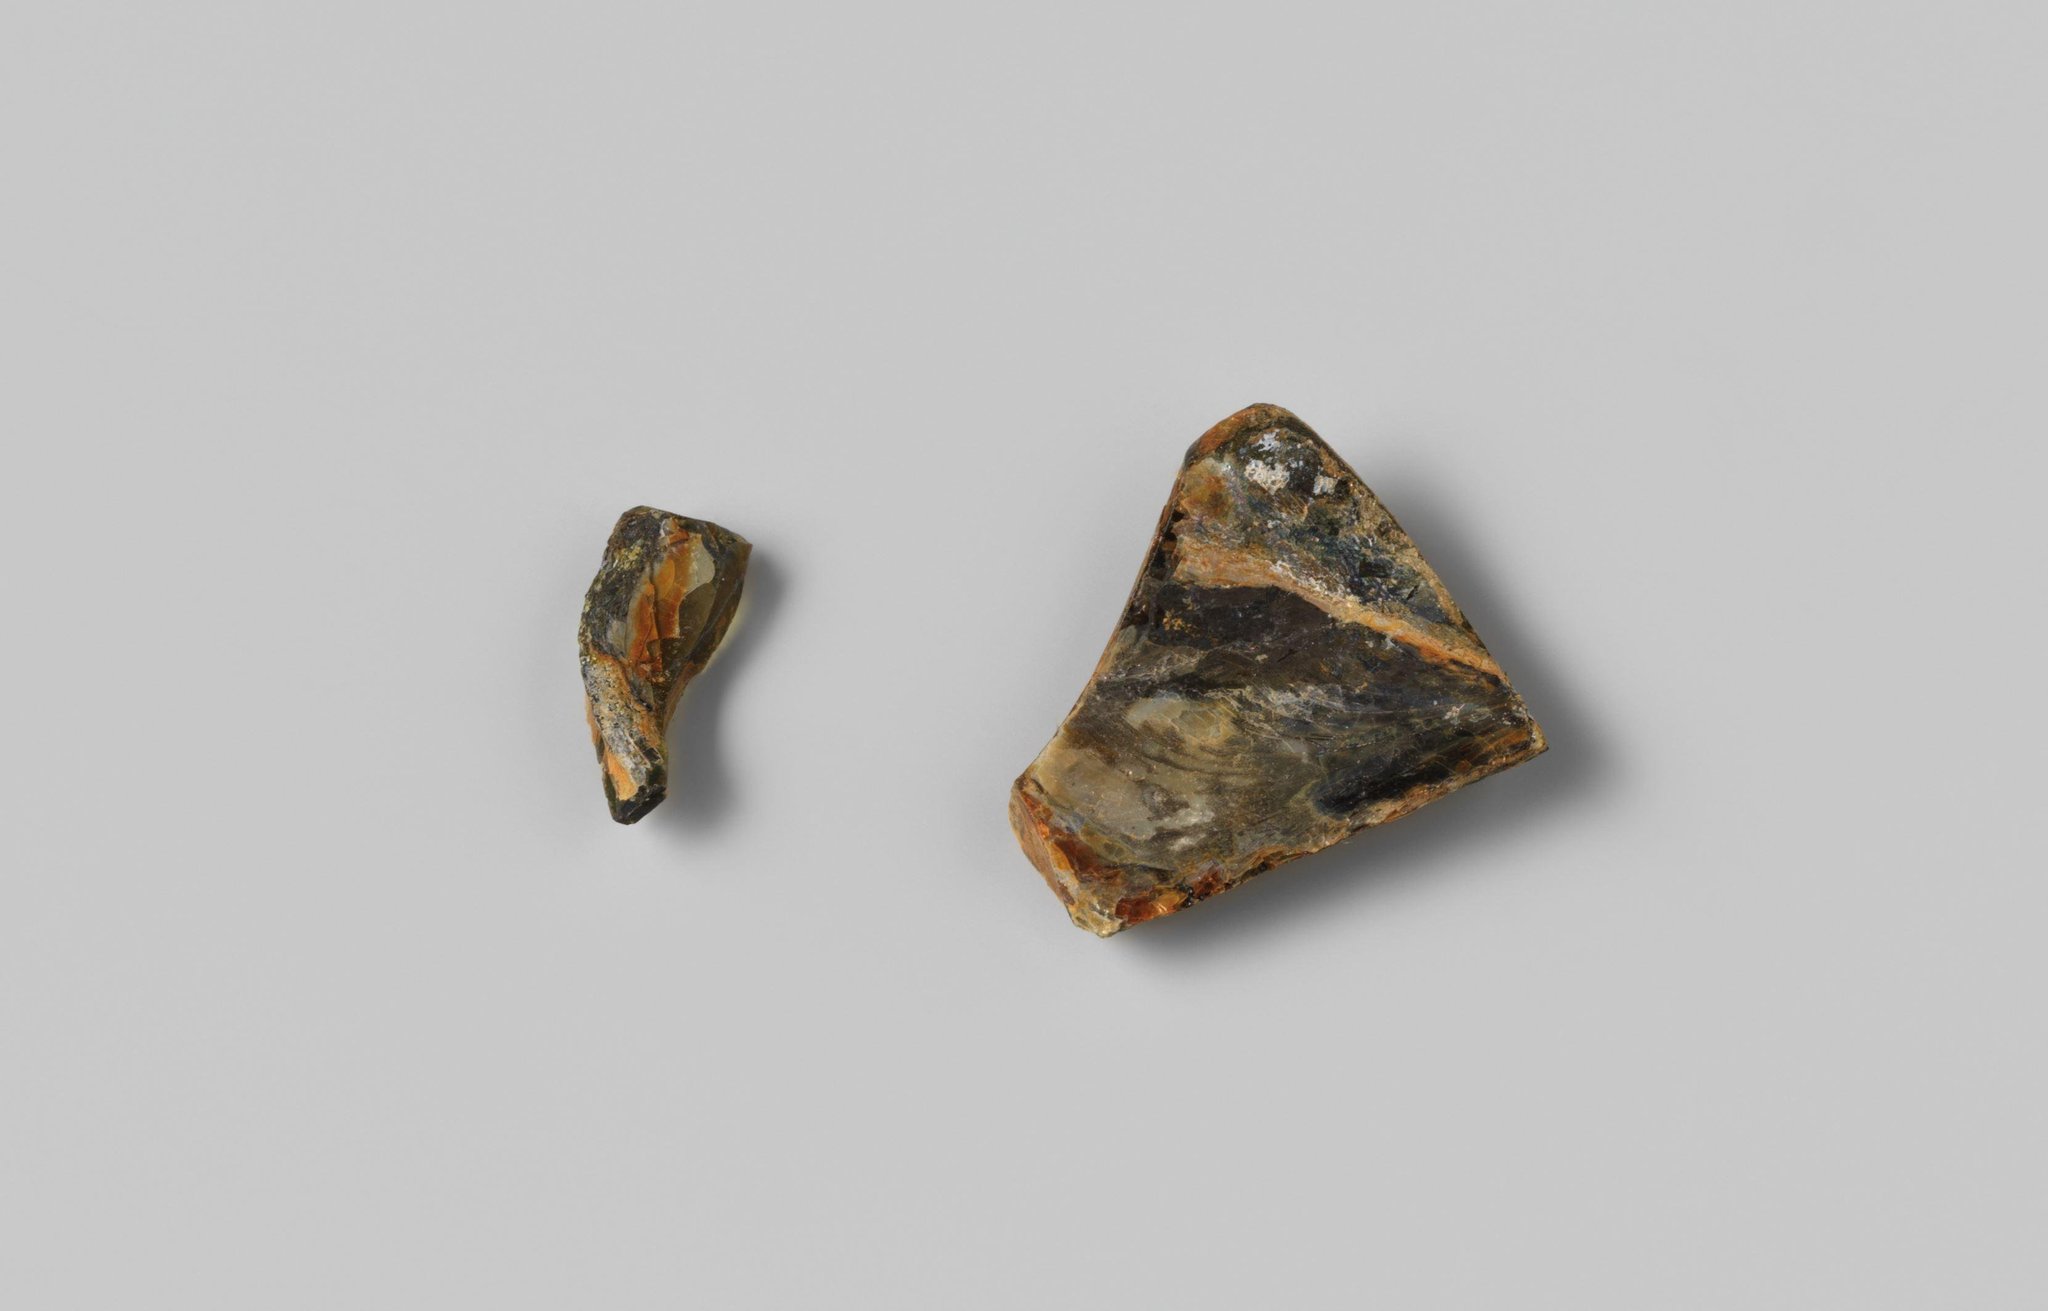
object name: wine bottle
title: Scherven van een wijnfles uit het wrak van de Oost-Indiëvaarder 't Vliegend Hart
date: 1700-1735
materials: glass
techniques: manufacturing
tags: 't vliegend hart (schip), verenigde oostindische compagnie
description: De twee fragmenten van een wijnfles zijn van groen, geïriseerd glas. Een fragment is bijna driehoekig, het andere is licht gewelfd.